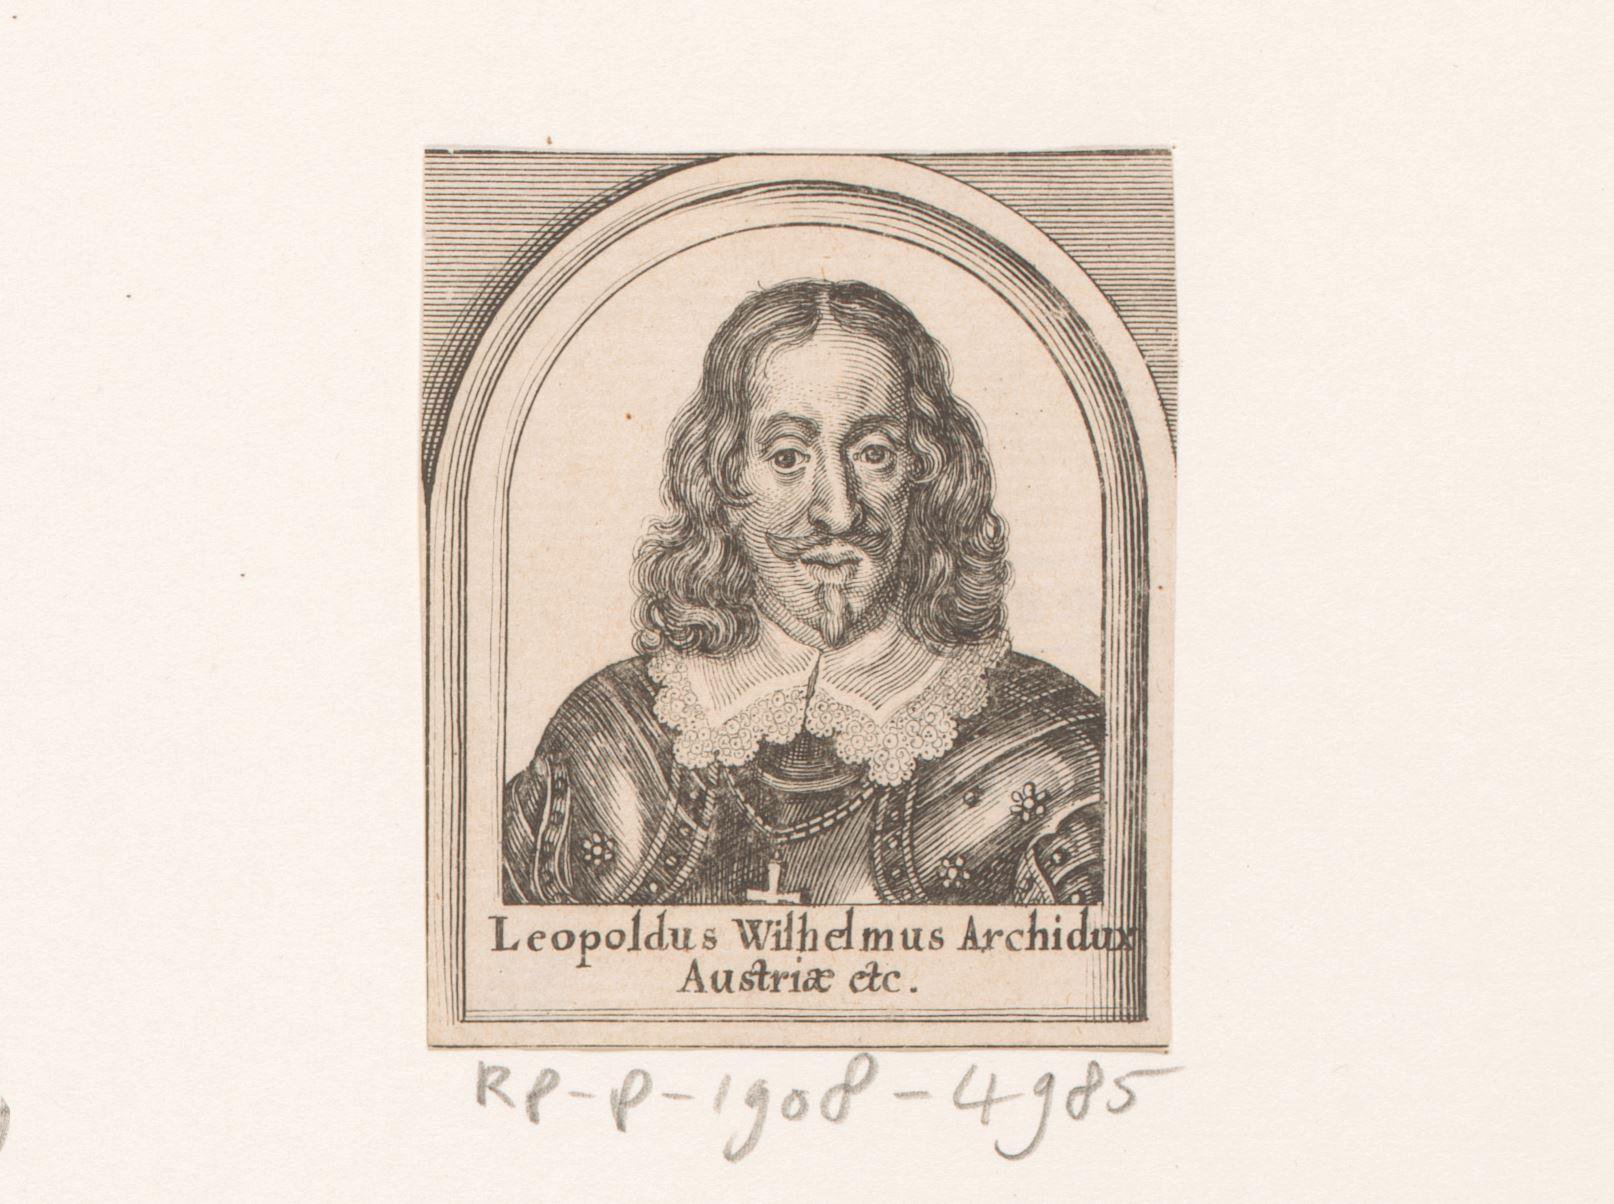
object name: print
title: Portret van Leopold Willem aartshertog van Oostenrijk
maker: matthäus merian (i)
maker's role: print maker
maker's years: 1593-1650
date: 1629-1650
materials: paper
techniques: engraving, etching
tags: vienna, leopold willem van oostenrijk (landvoogd der zuidelijke nederlanden), armour, historical persons, crucifix ~ personal devotion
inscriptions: collector's mark: Lugt 2228